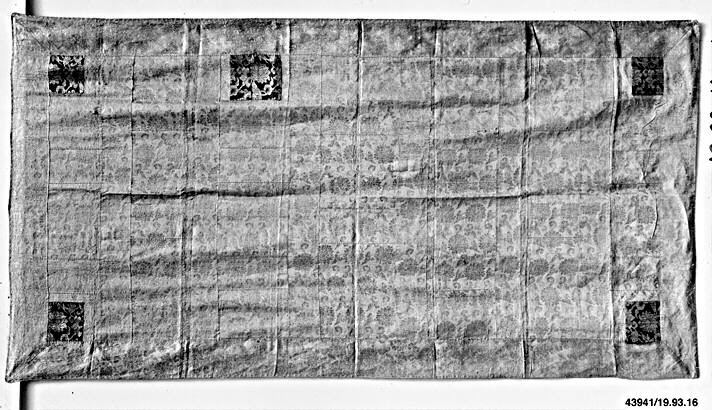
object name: robe, priest's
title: Priest's Robe (Shichijō)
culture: japanese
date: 1401-1500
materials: metal thread, silk